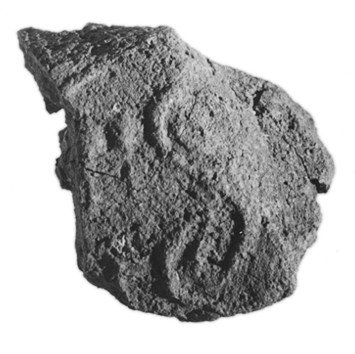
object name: sealing fragment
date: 2030-1640 BCE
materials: clay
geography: egypt